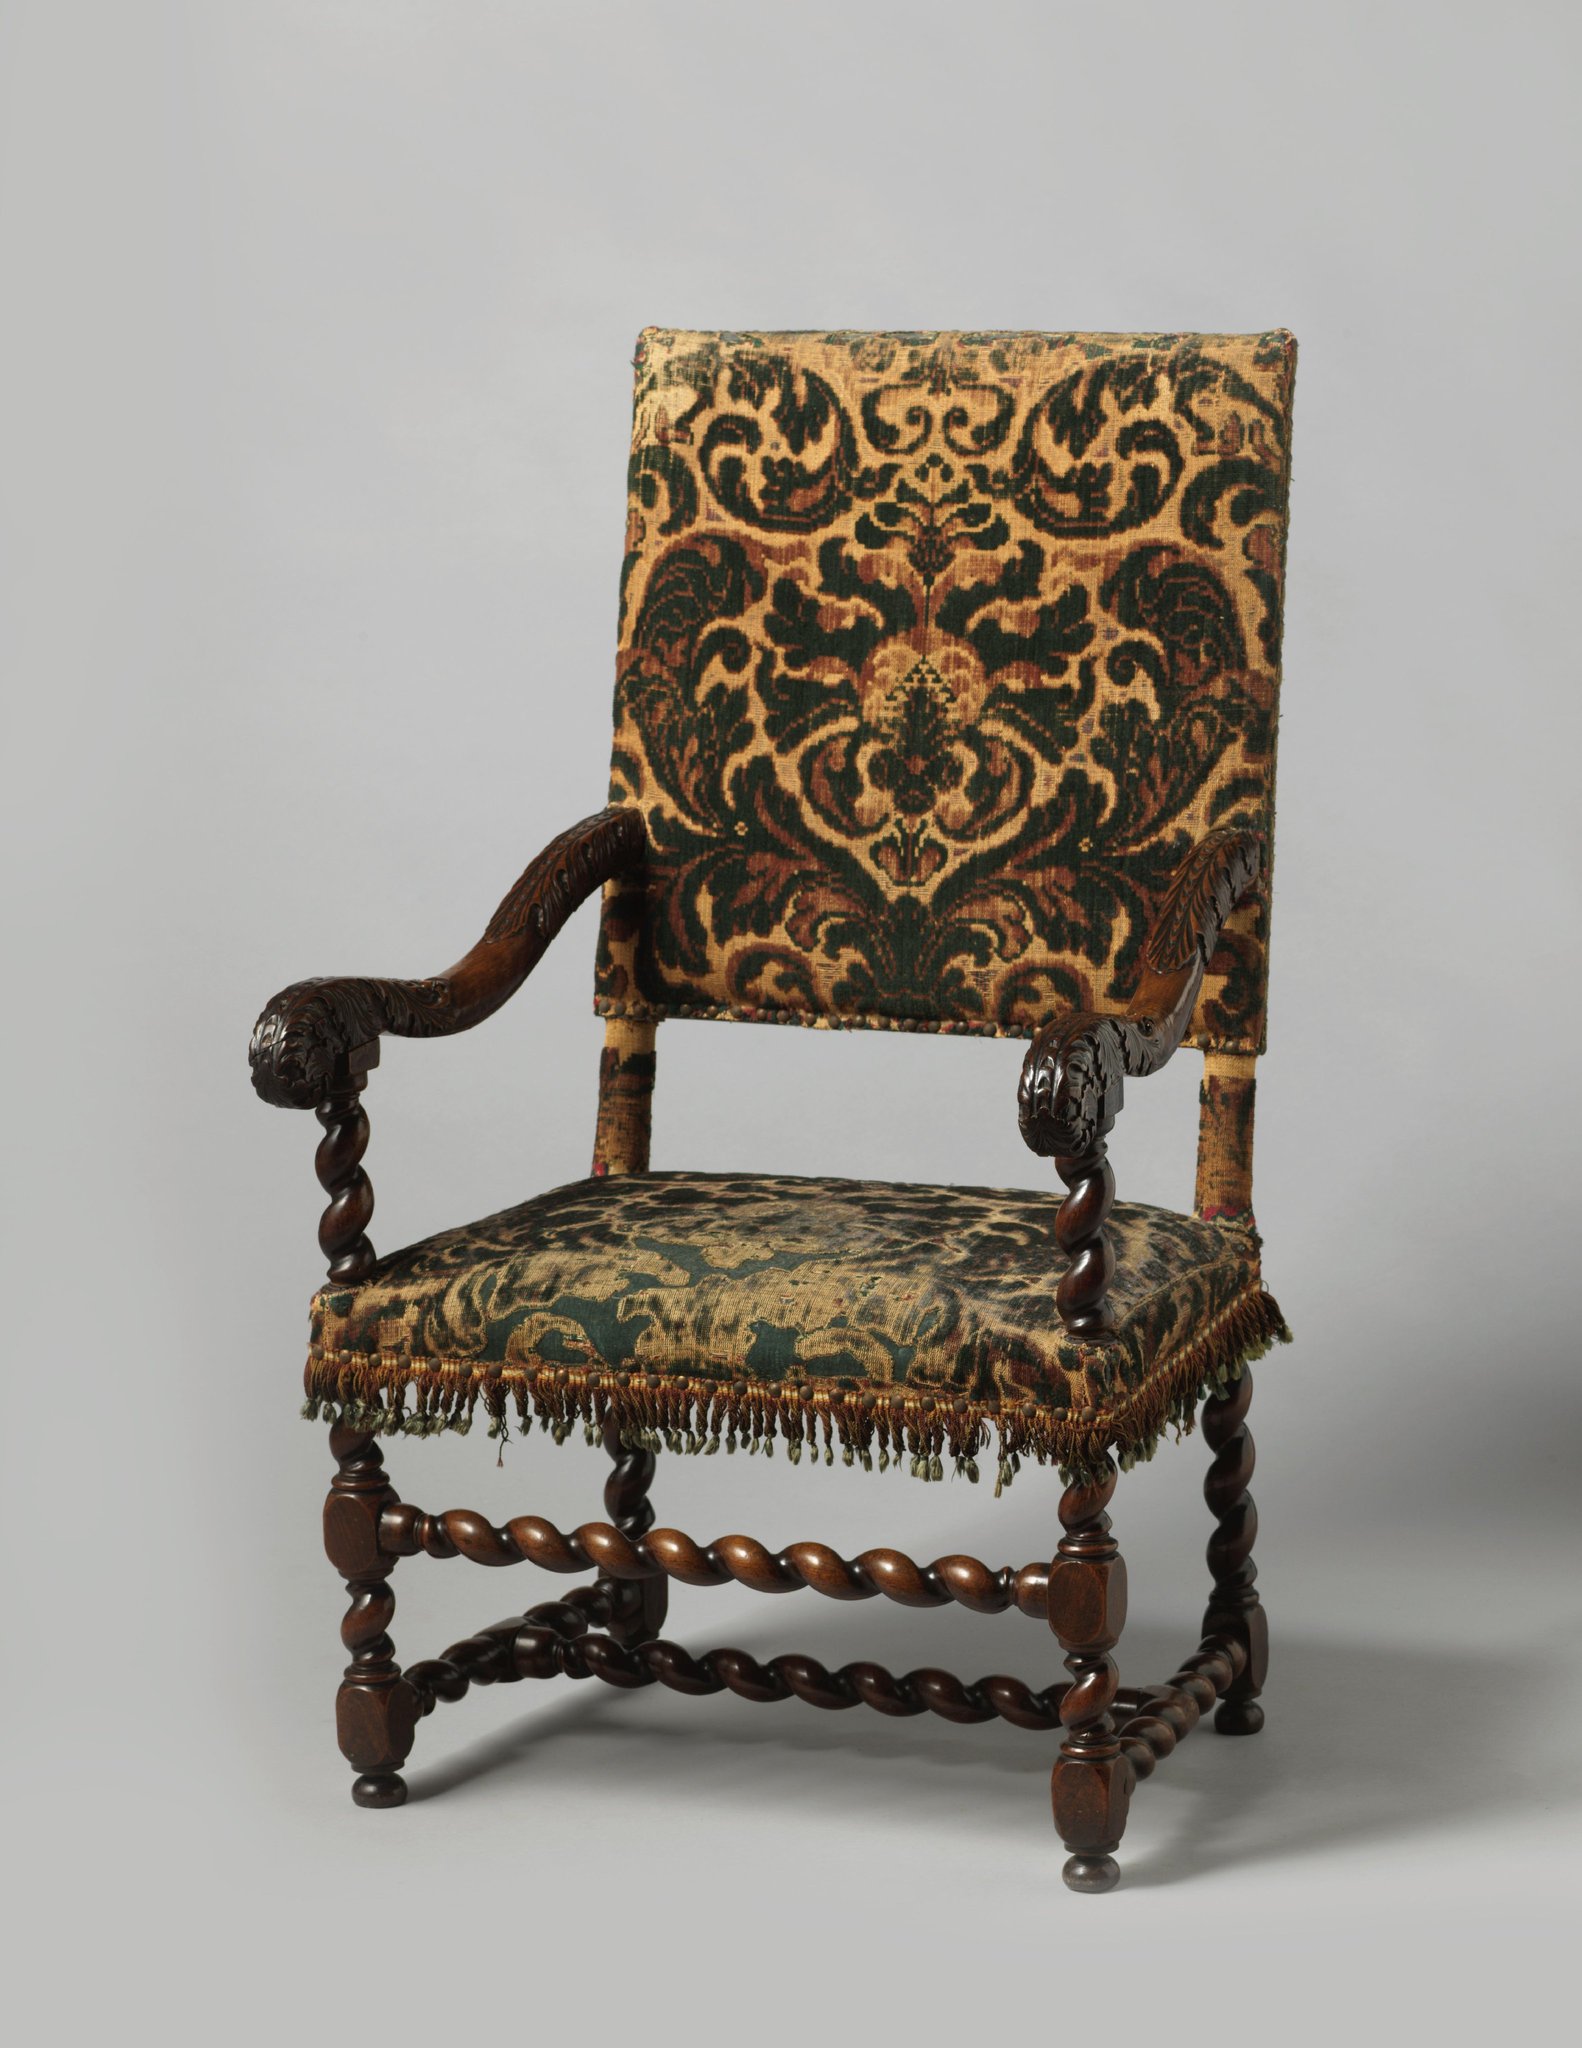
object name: armchair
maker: Anonymous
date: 1675-1700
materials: textile, wood, wool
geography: northern netherlands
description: The rich carvings and colourful fabric of this chair made it one of the most important pieces of seat furniture in a late 17th-century interior. It was therefore placed in the best room of the house, as can be seen in the doll’s house opposite this display case. Such chairs came with a cover to protect the precious upholstery on the back and seat from sunlight and wear.